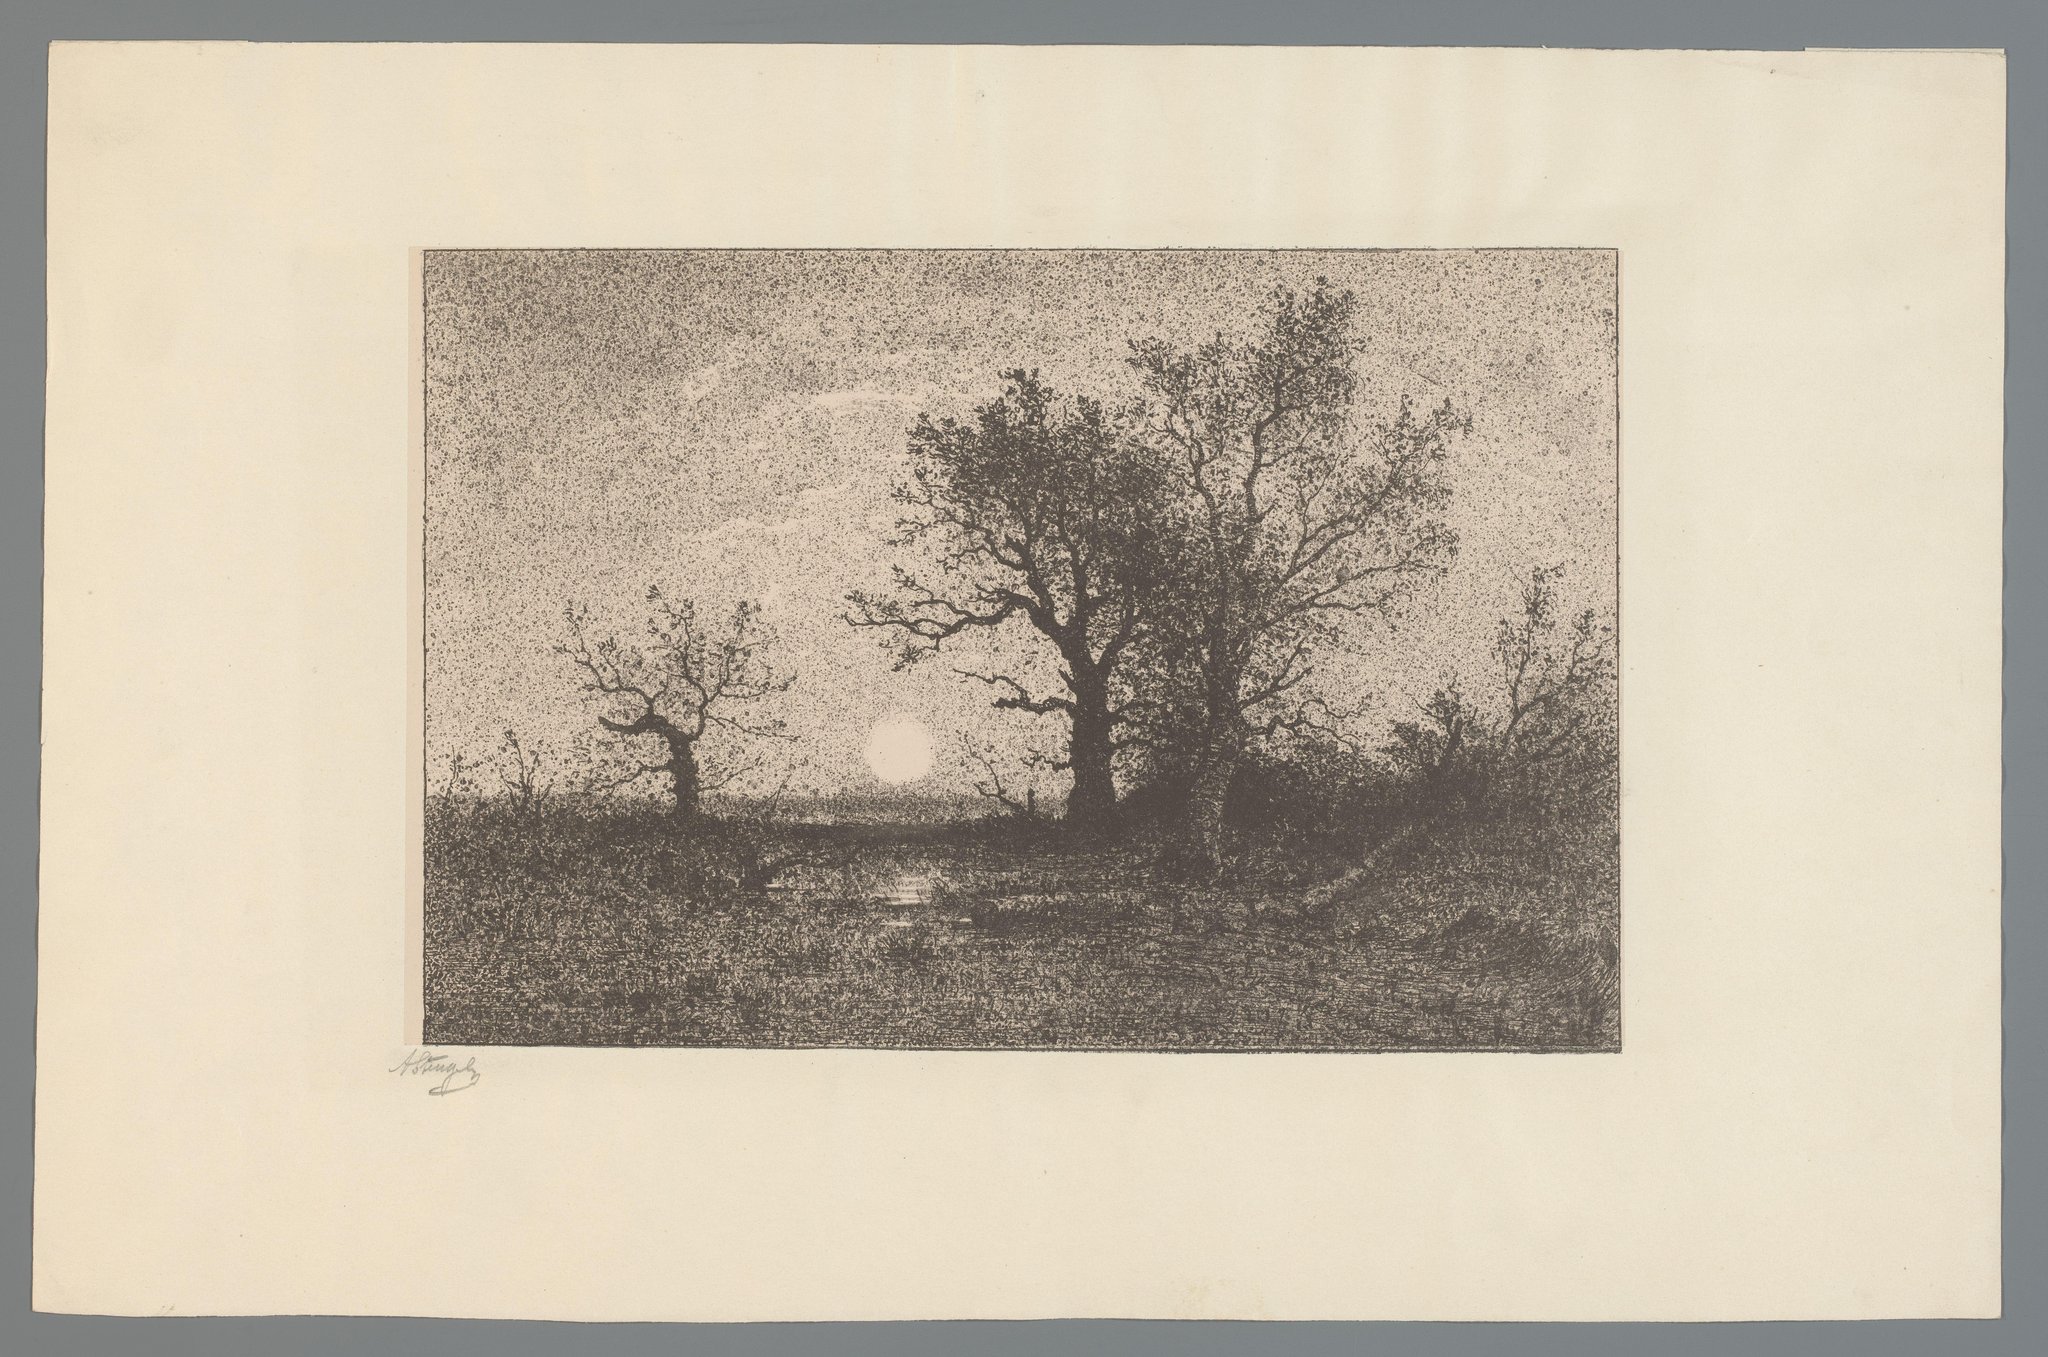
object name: print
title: Lever de lune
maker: alphonse stengelin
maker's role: painter, print maker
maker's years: 1852-1938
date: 1876-1910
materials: paper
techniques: lithograph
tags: moonrise, trees, landscapes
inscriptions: collector's mark: Lugt 2228